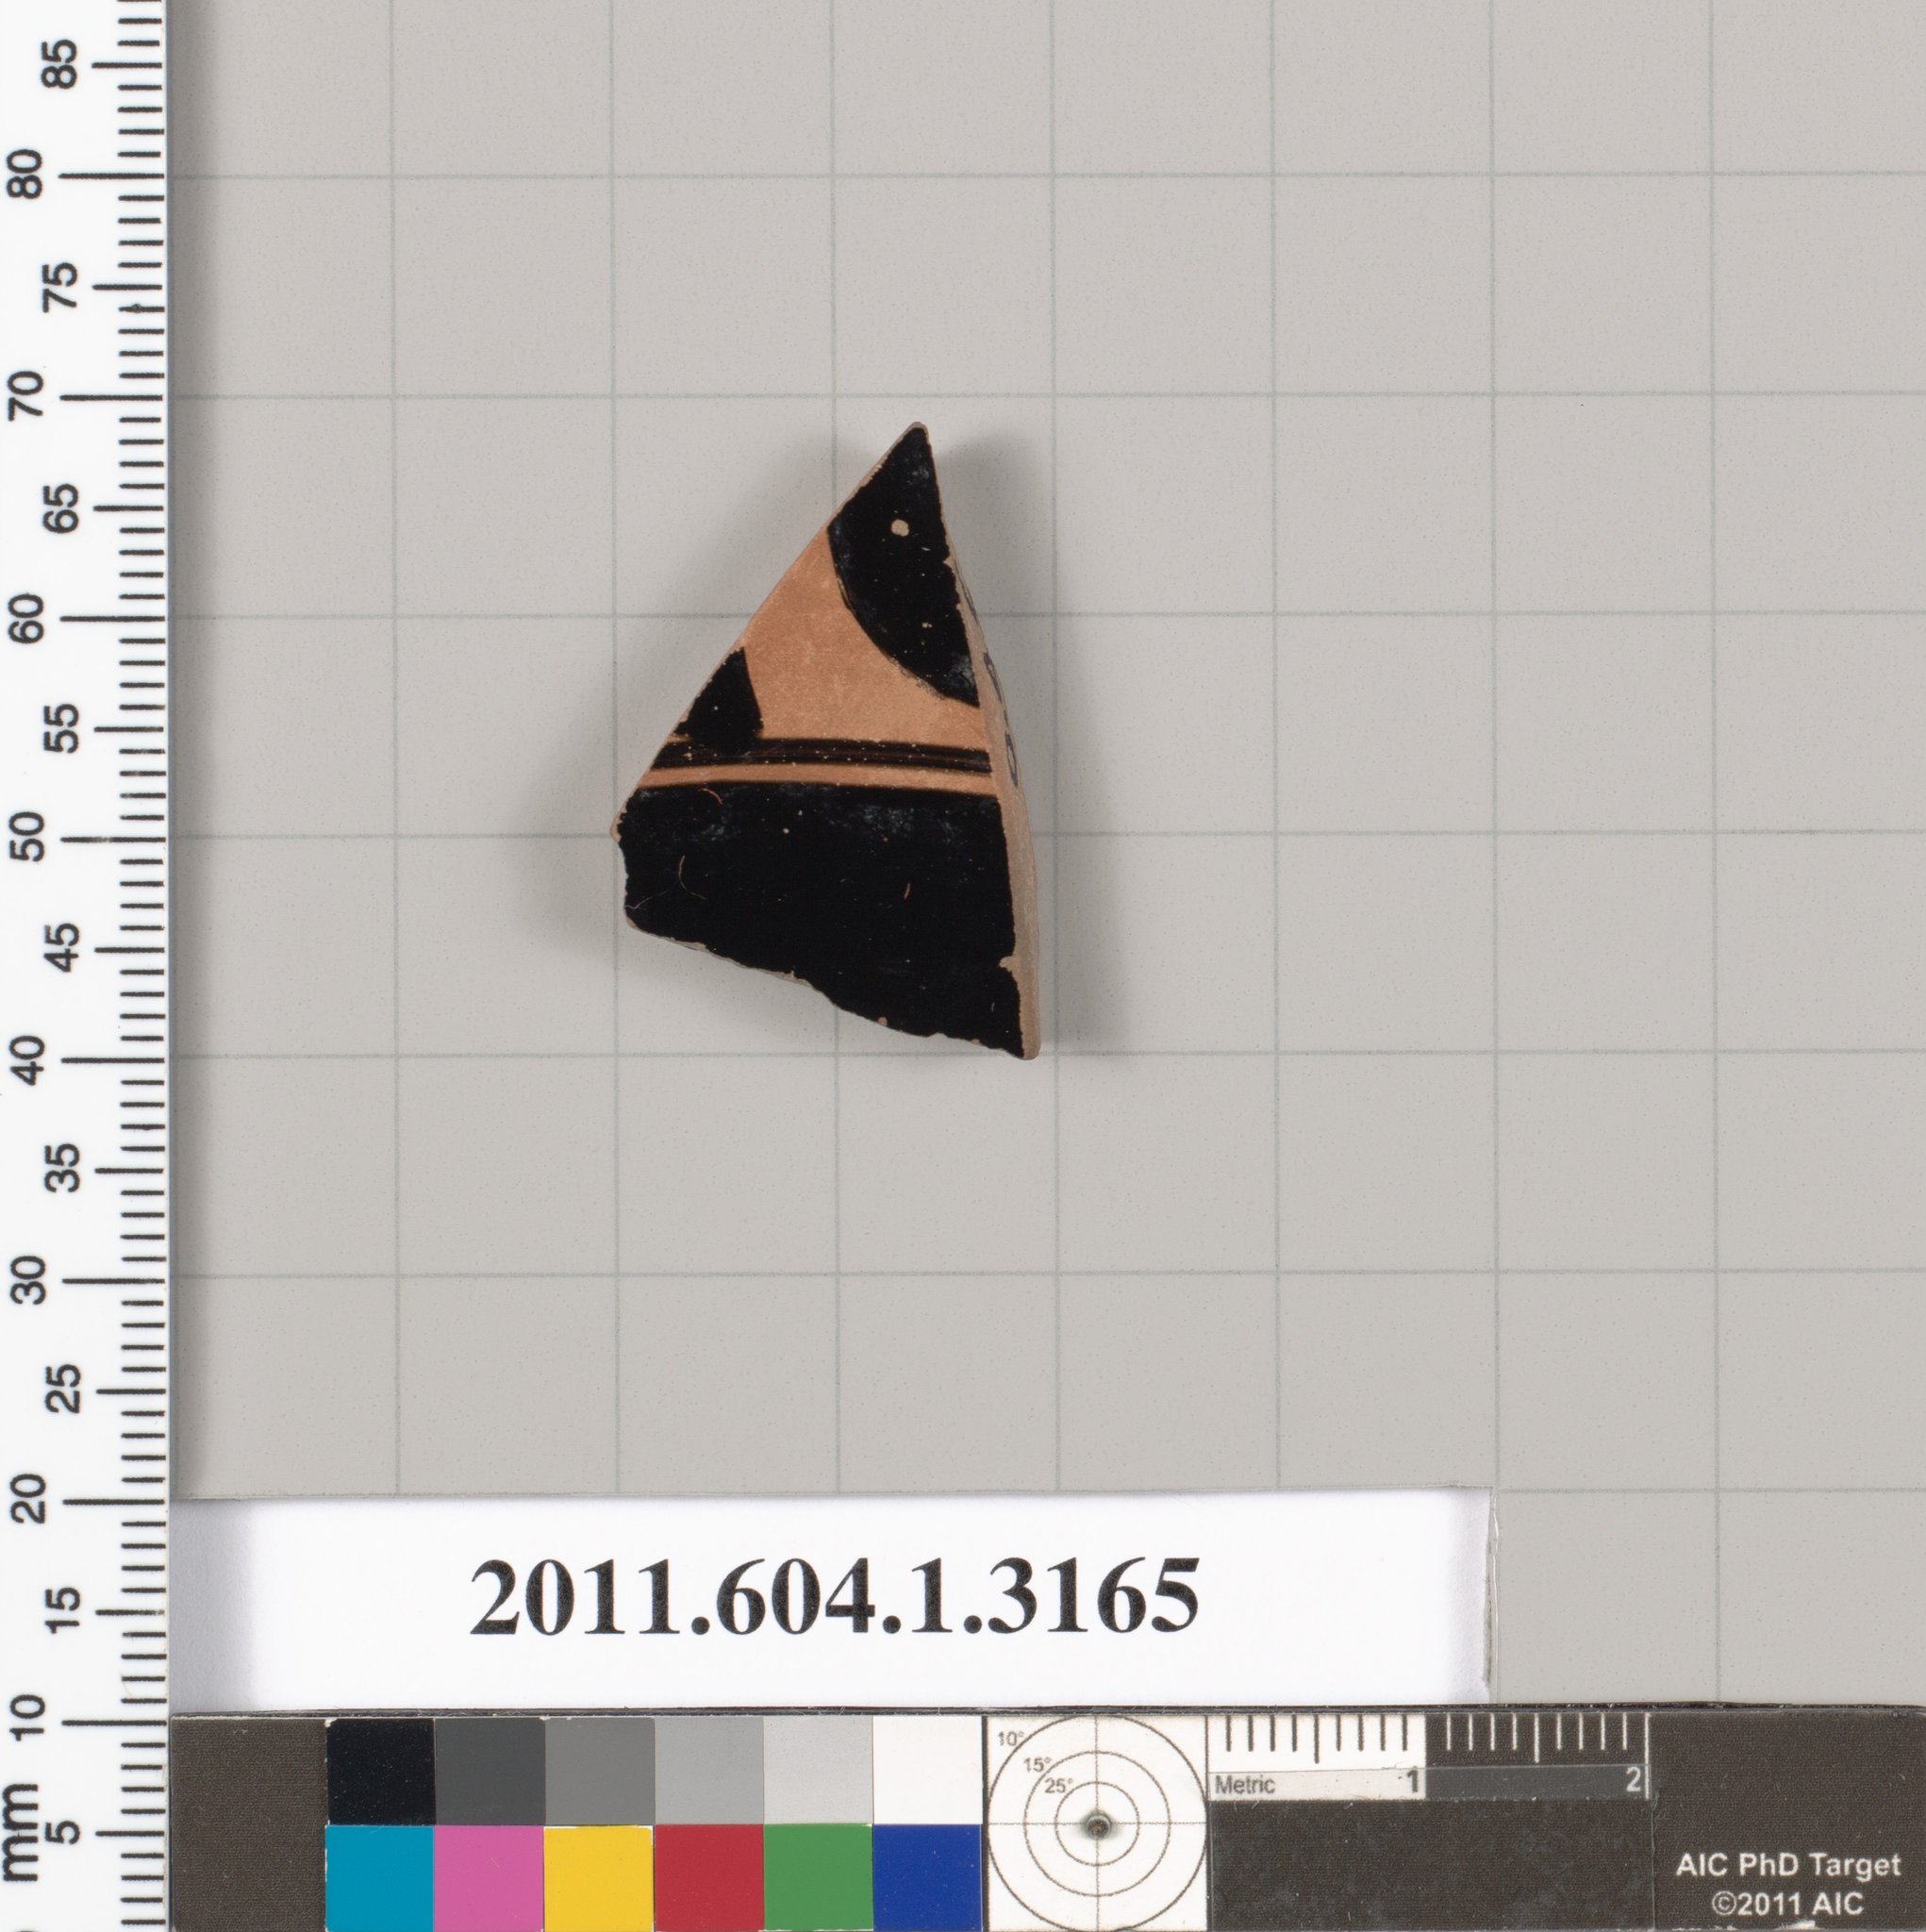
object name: kylix fragment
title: Terracotta fragment of a kylix (drinking cup)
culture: greek, attic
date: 500-451 BCE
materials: terracotta